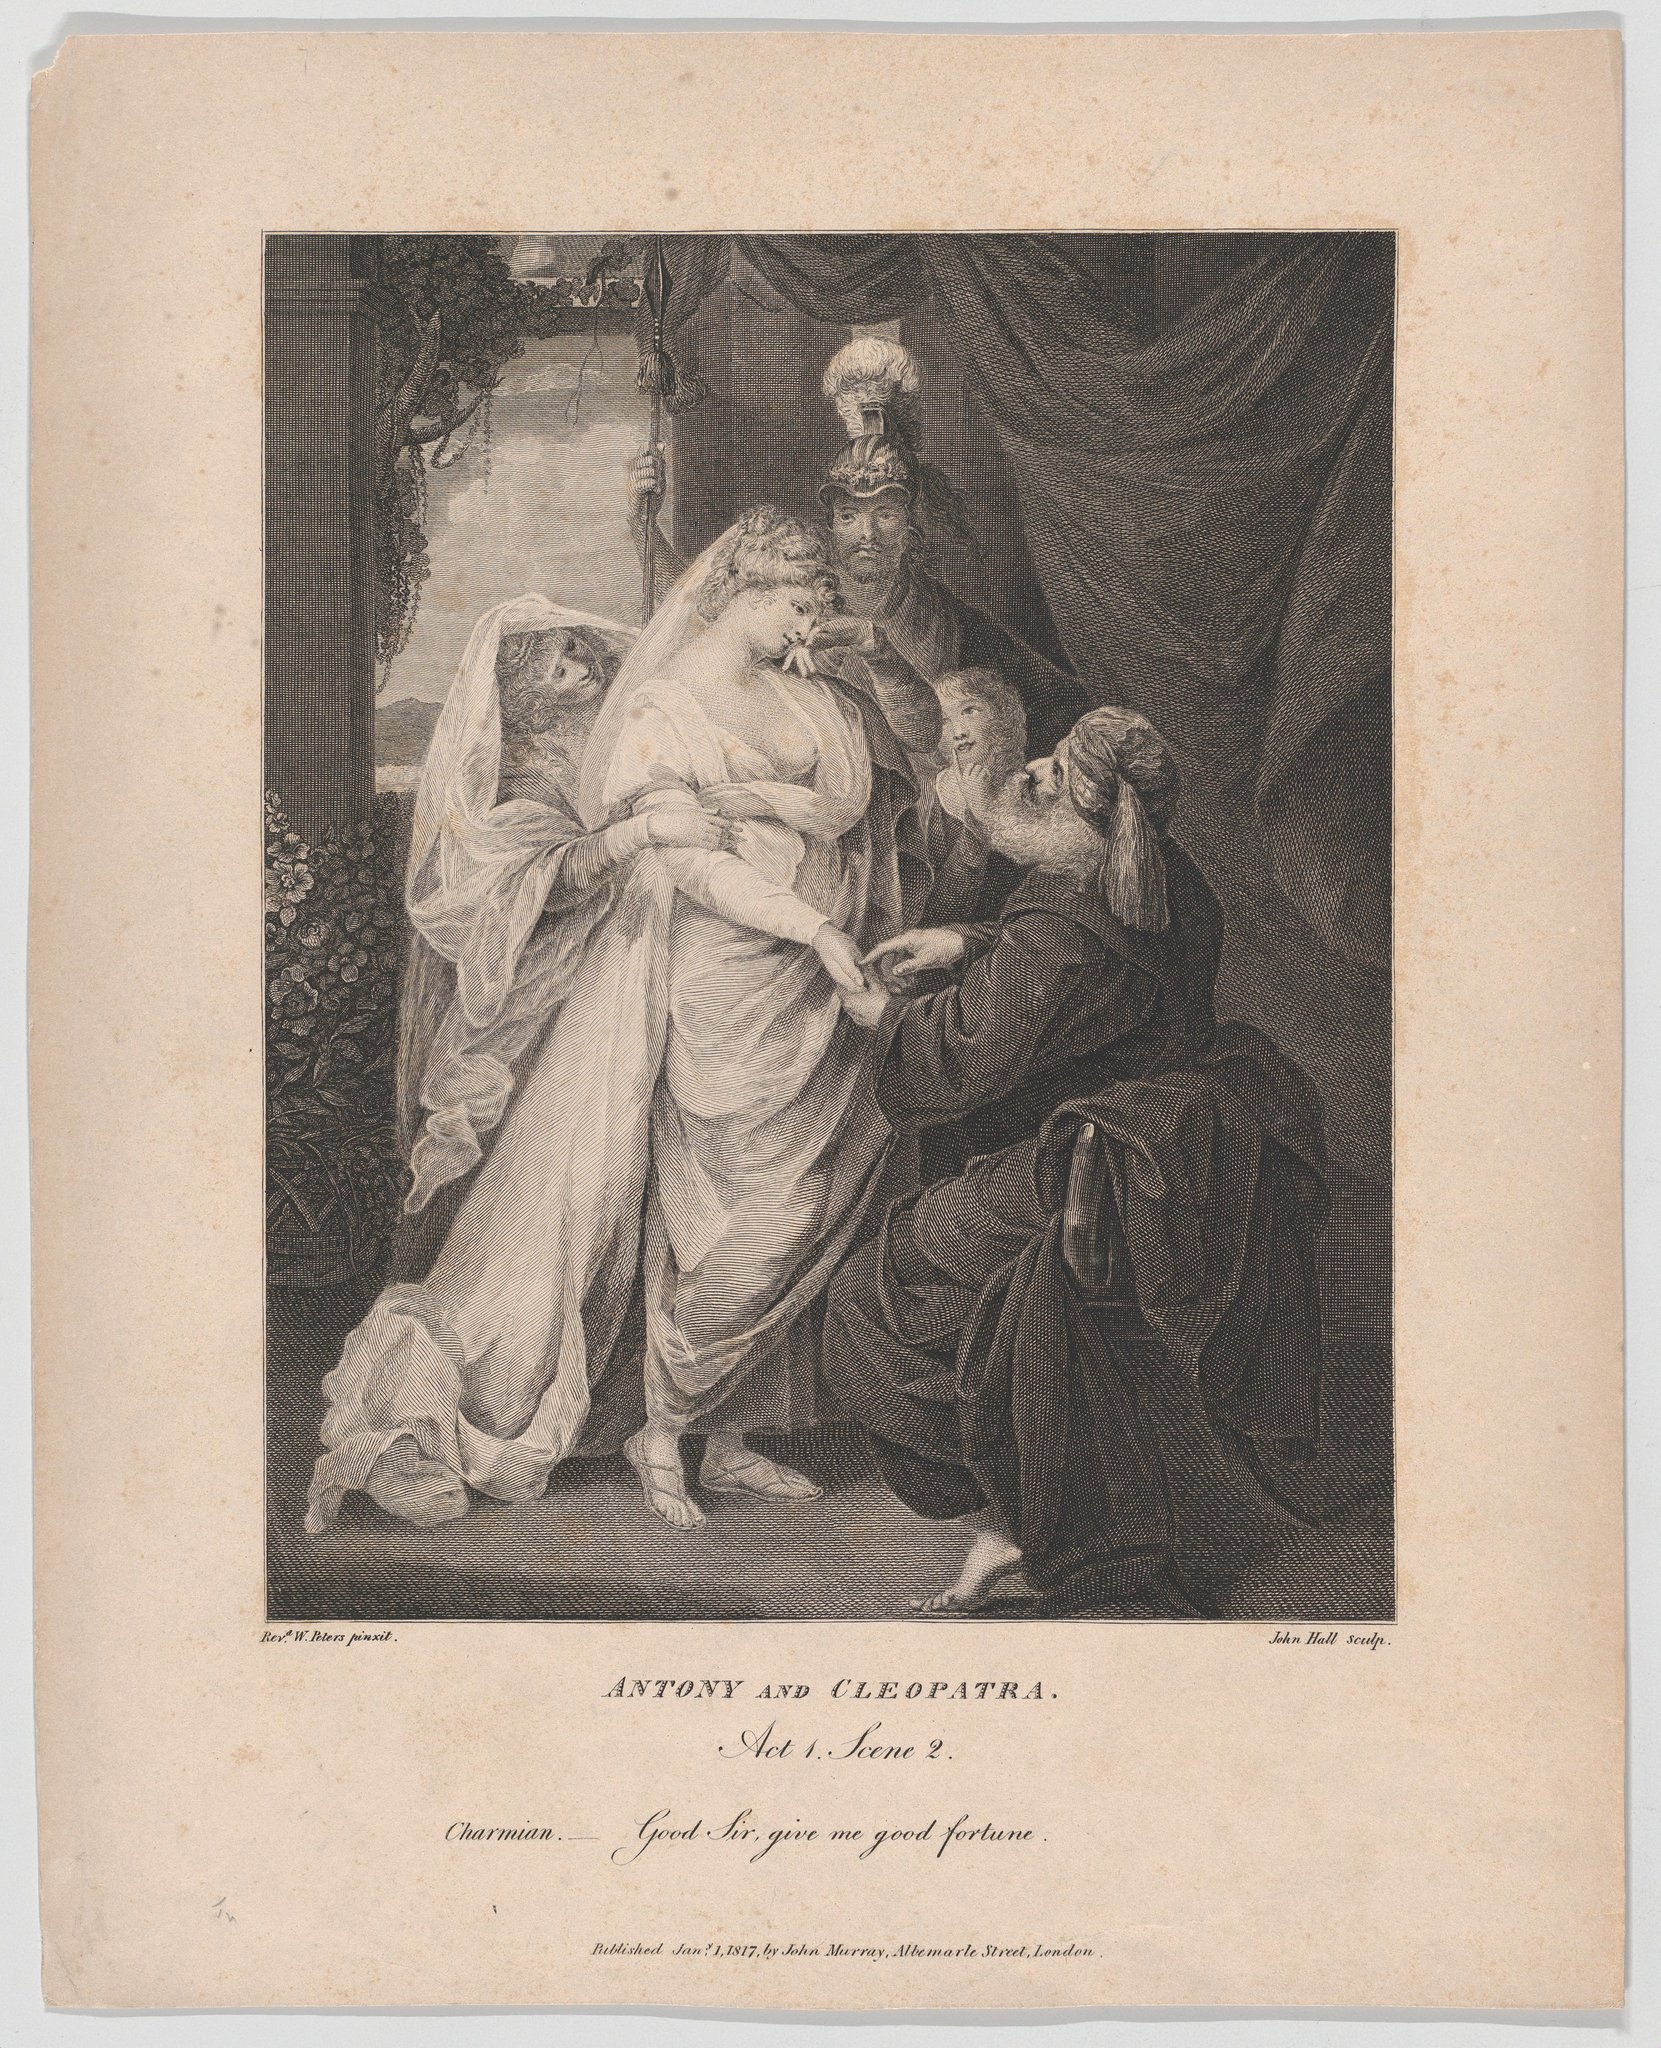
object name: print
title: Antony and Cleopatra, Act 1, Scene 2: Charmian–"Good Sir, give me good fortune"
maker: john hall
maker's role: engraver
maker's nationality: british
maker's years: 1739-1797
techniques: engraving, etching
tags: cleopatra,mark antony,shakespeare,women